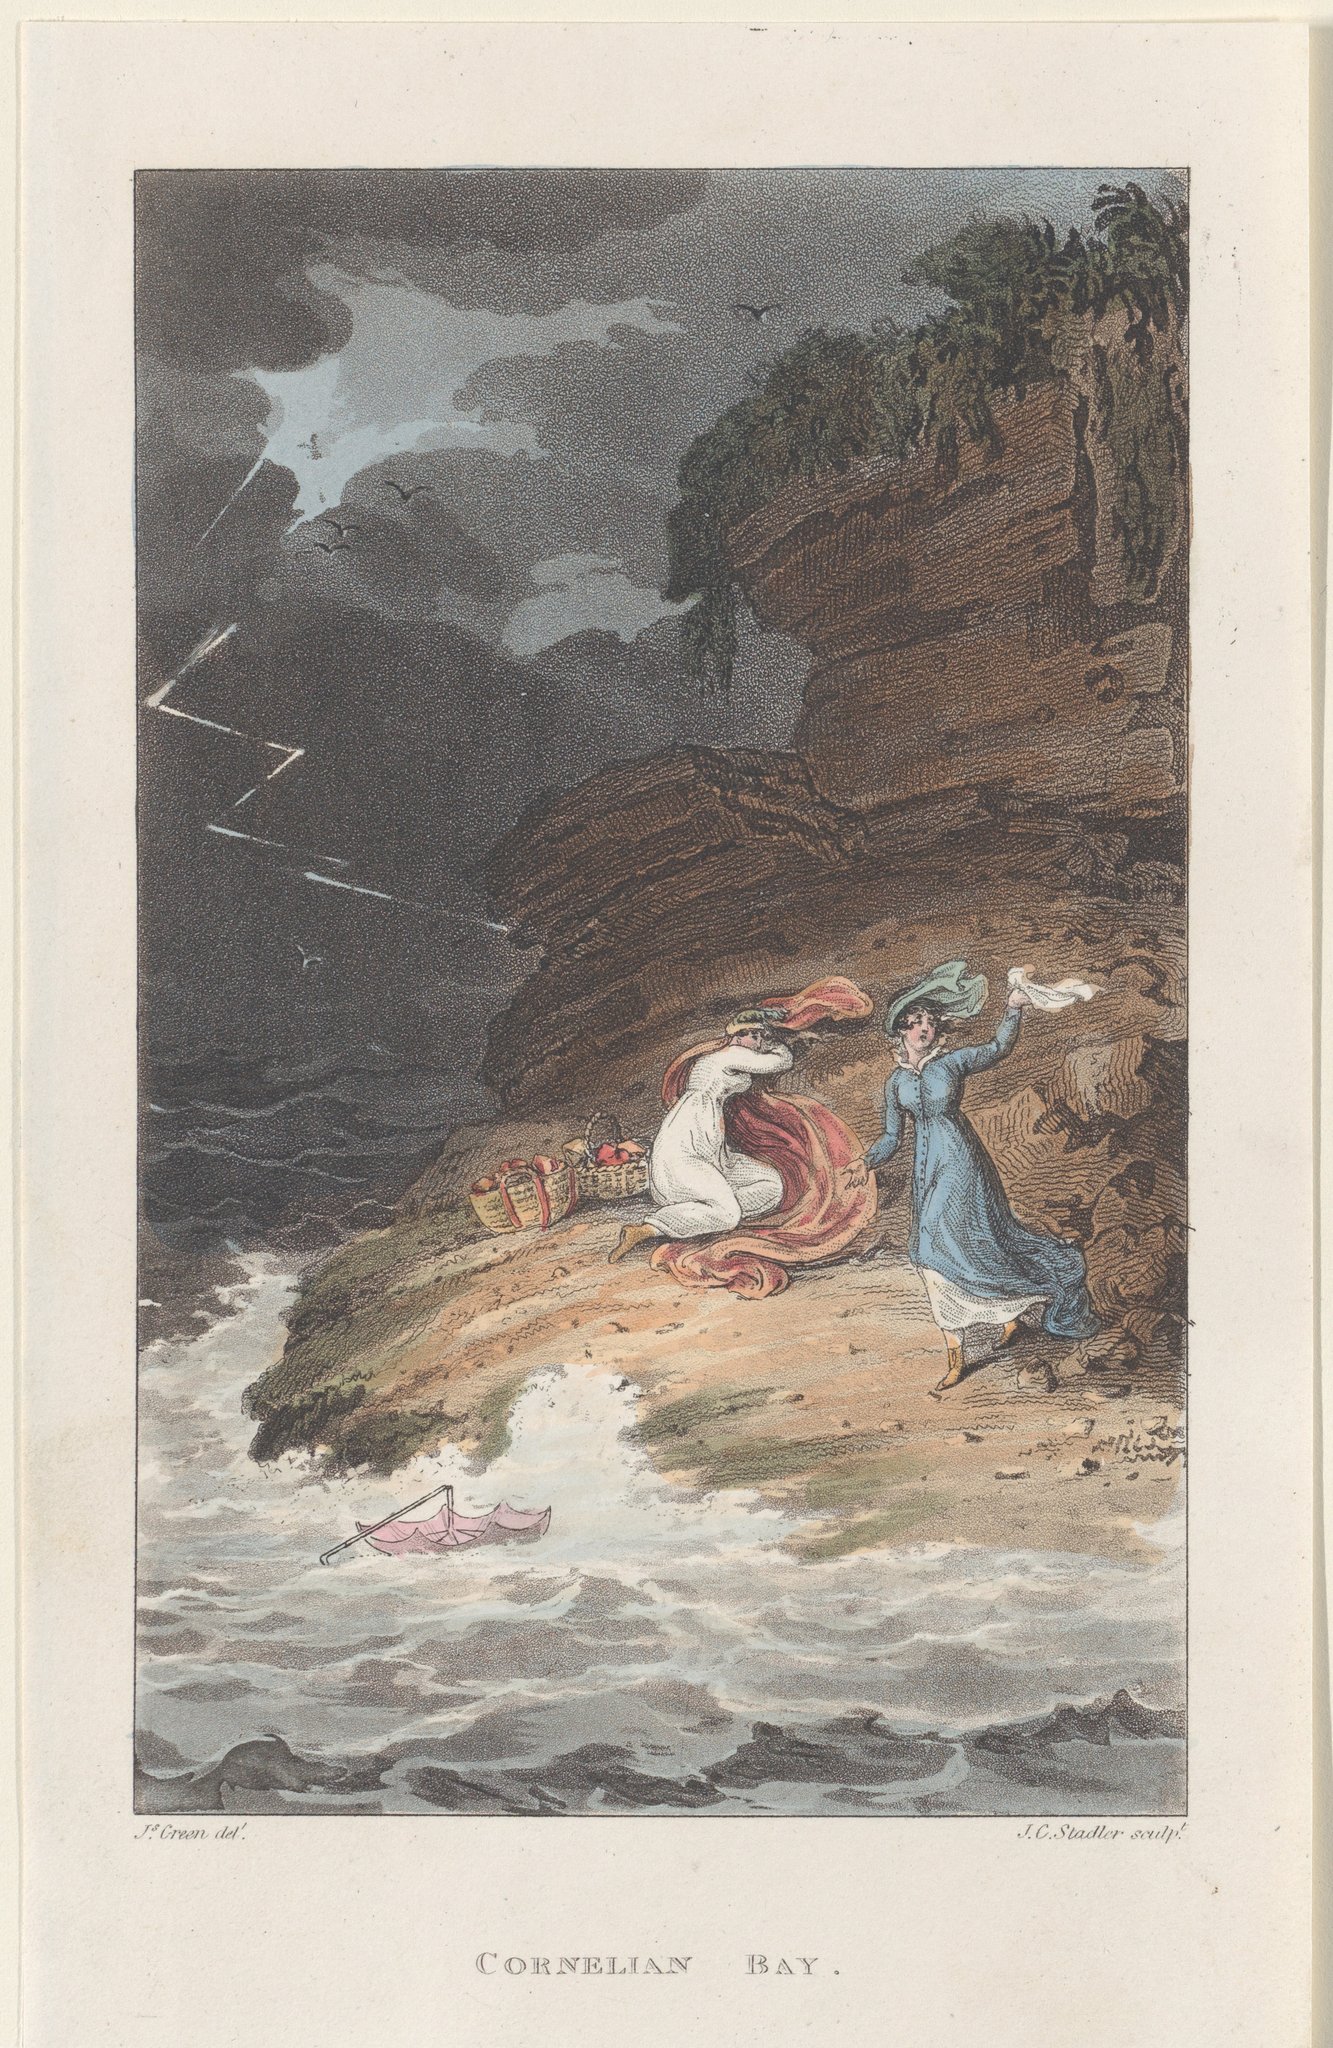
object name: print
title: Cornelian Bay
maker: thomas rowlandson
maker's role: artist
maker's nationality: british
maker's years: 1757-1827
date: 1813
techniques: aquatint, etching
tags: women,beaches